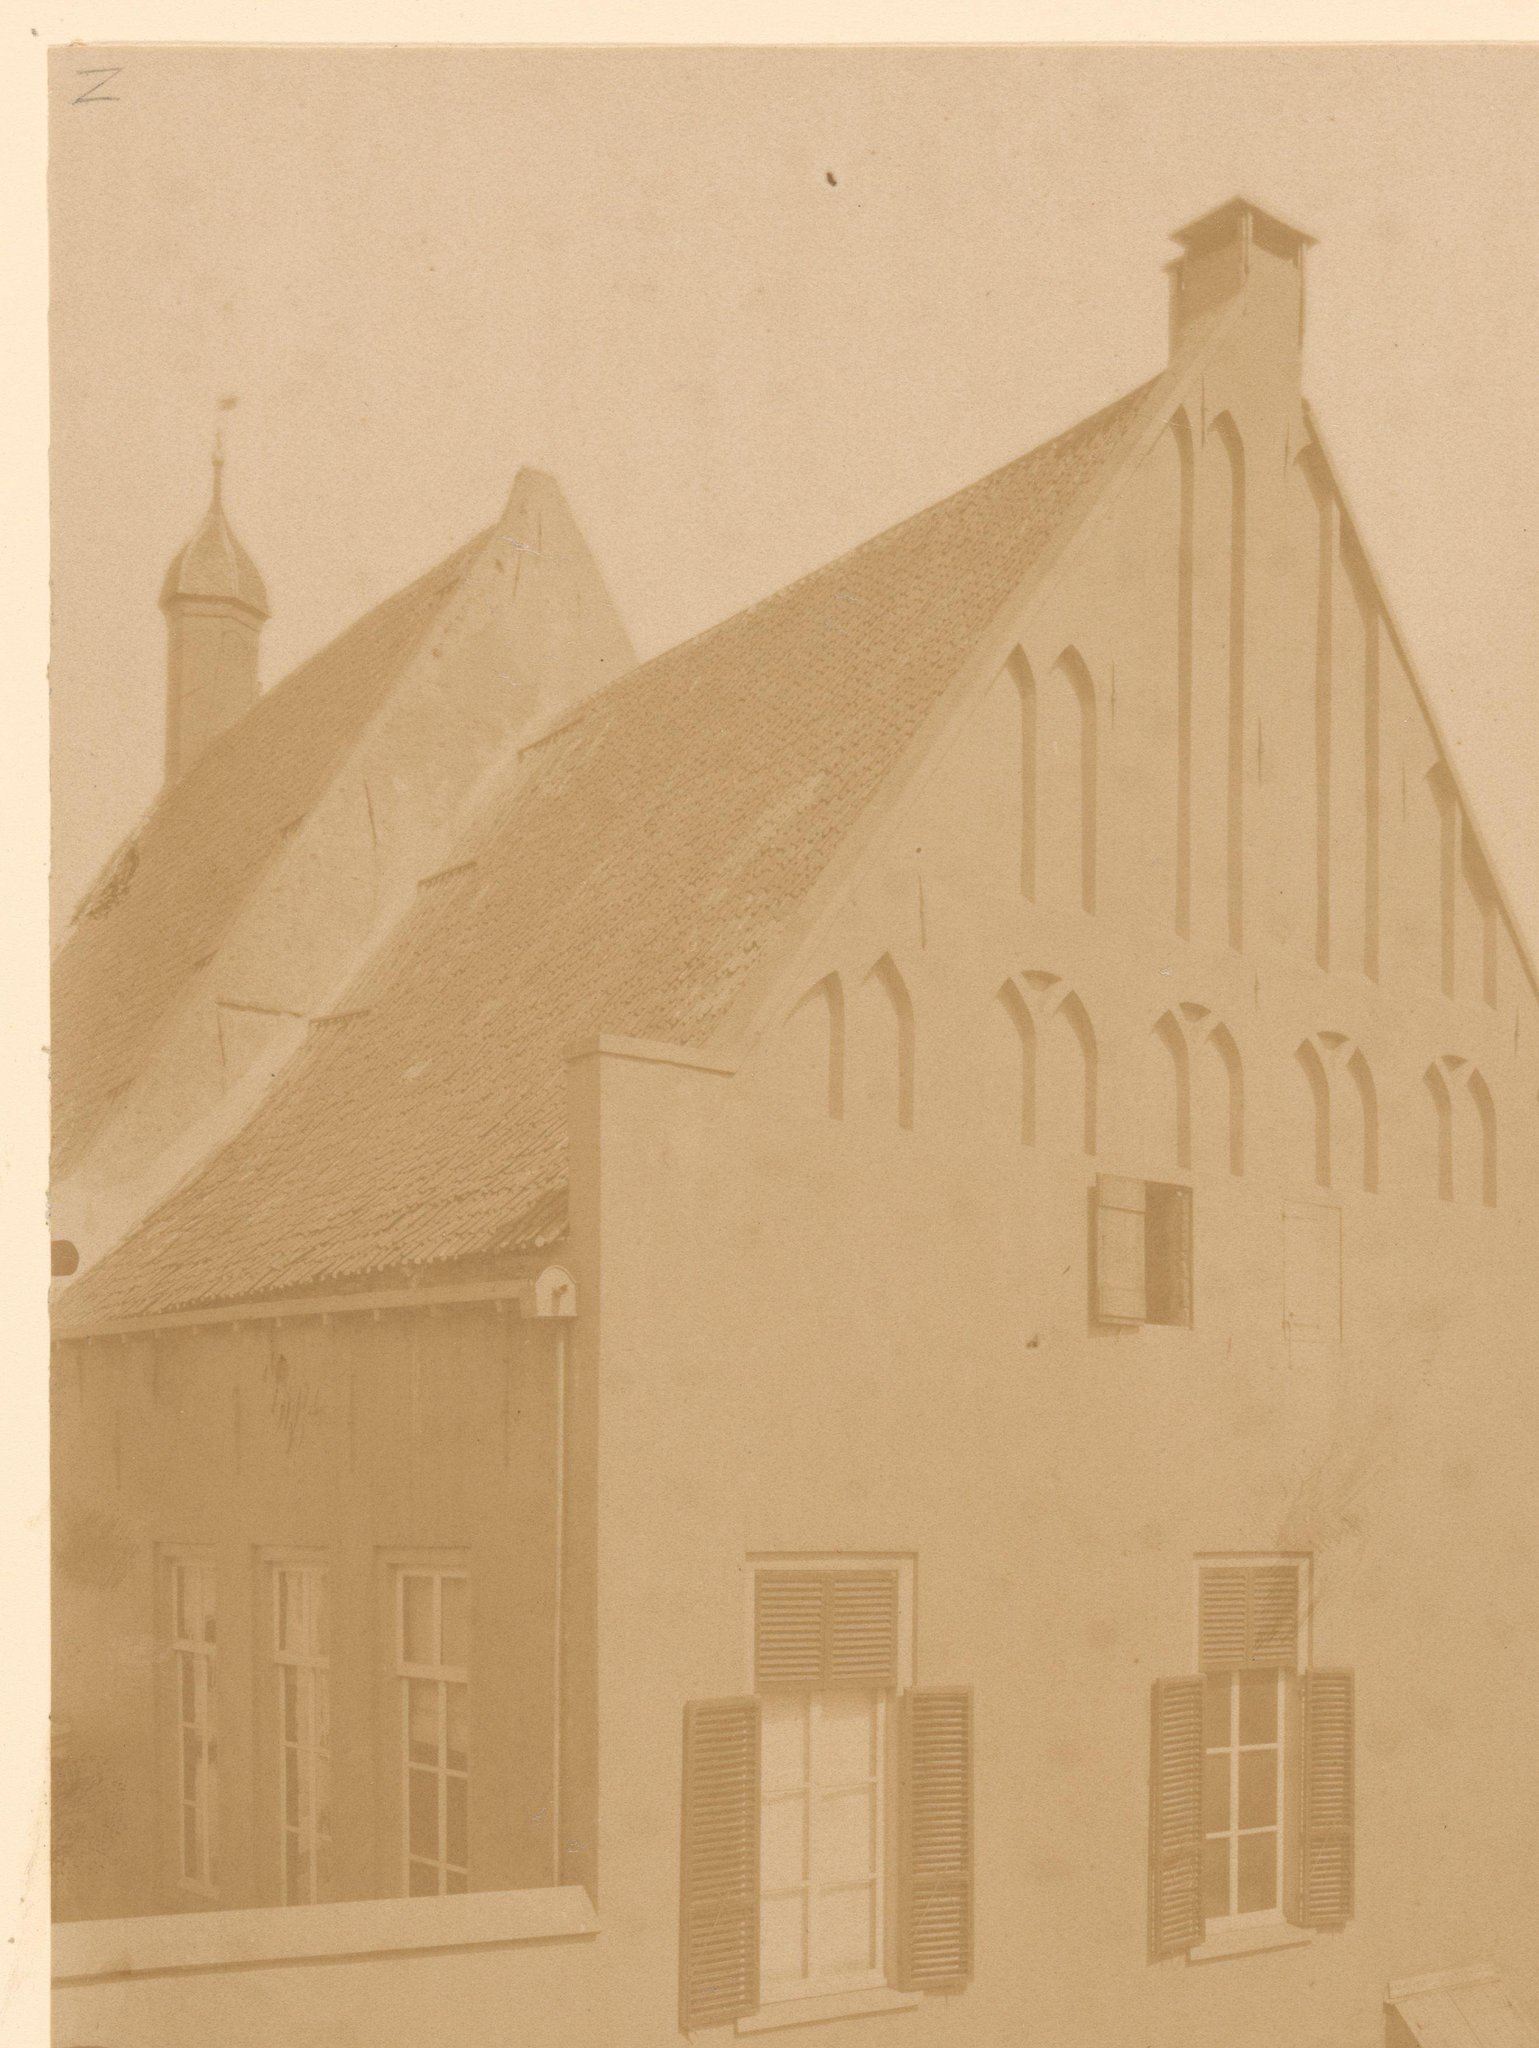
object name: photograph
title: Achterzijde van het stadhuis te Doesburg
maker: anoniem (monumentenzorg)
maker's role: fotograaf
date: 1890-1920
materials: cardboard, photographic support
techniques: albumen print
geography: doesburg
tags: townhall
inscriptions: annotation: ‘Doesburg/ de achterzijde v/h raadhuis’, annotation: ‘Z’